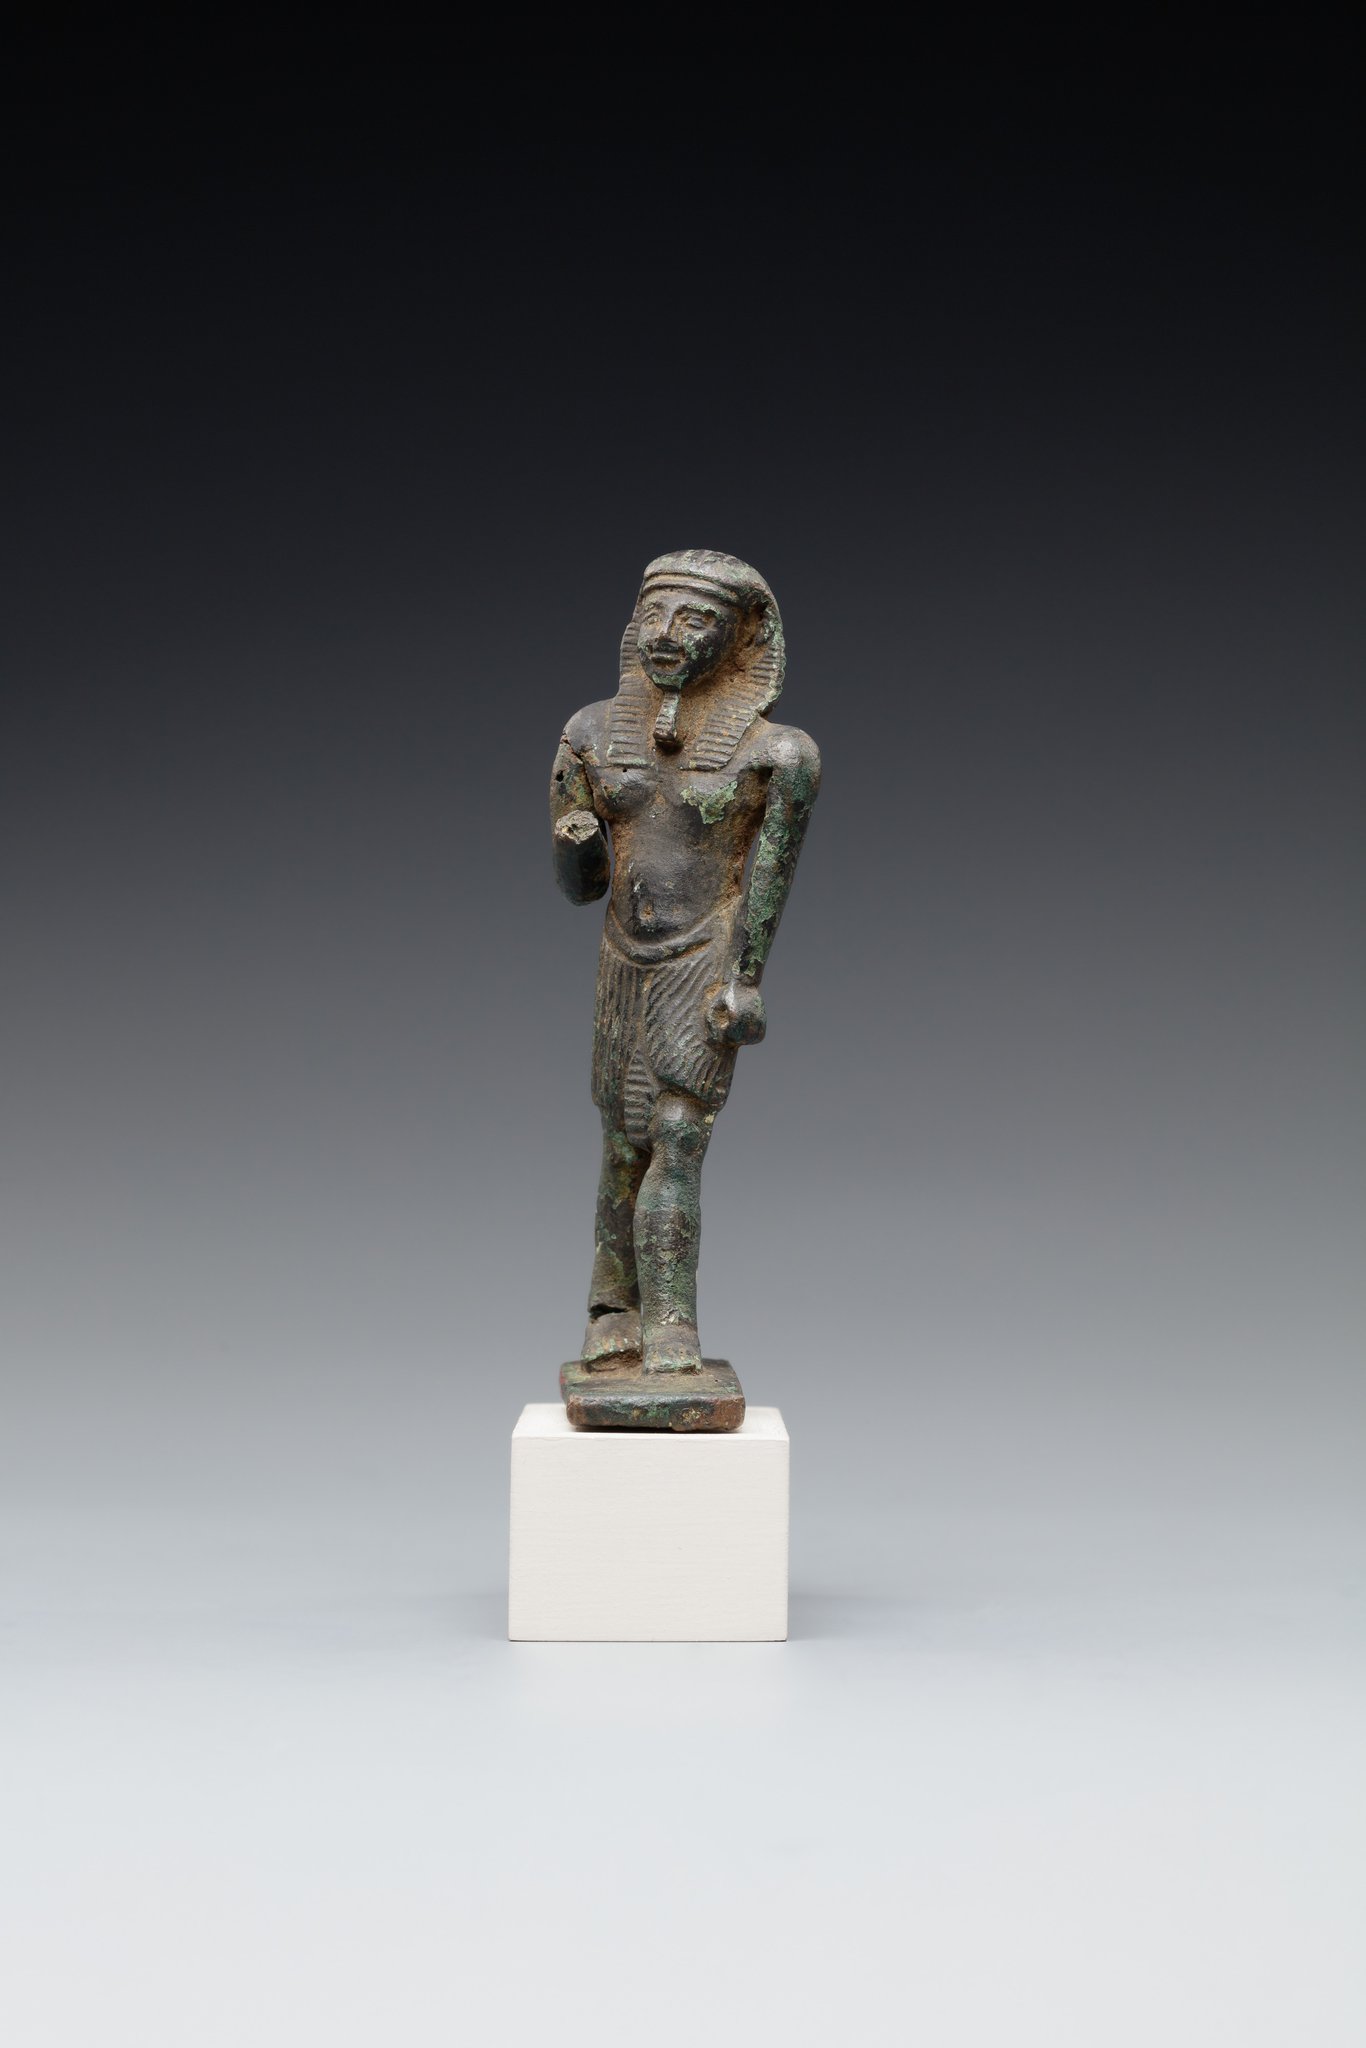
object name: statuette, nemes, raised arm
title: Male figure in a nemes and shendyt kilt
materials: bronze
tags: men